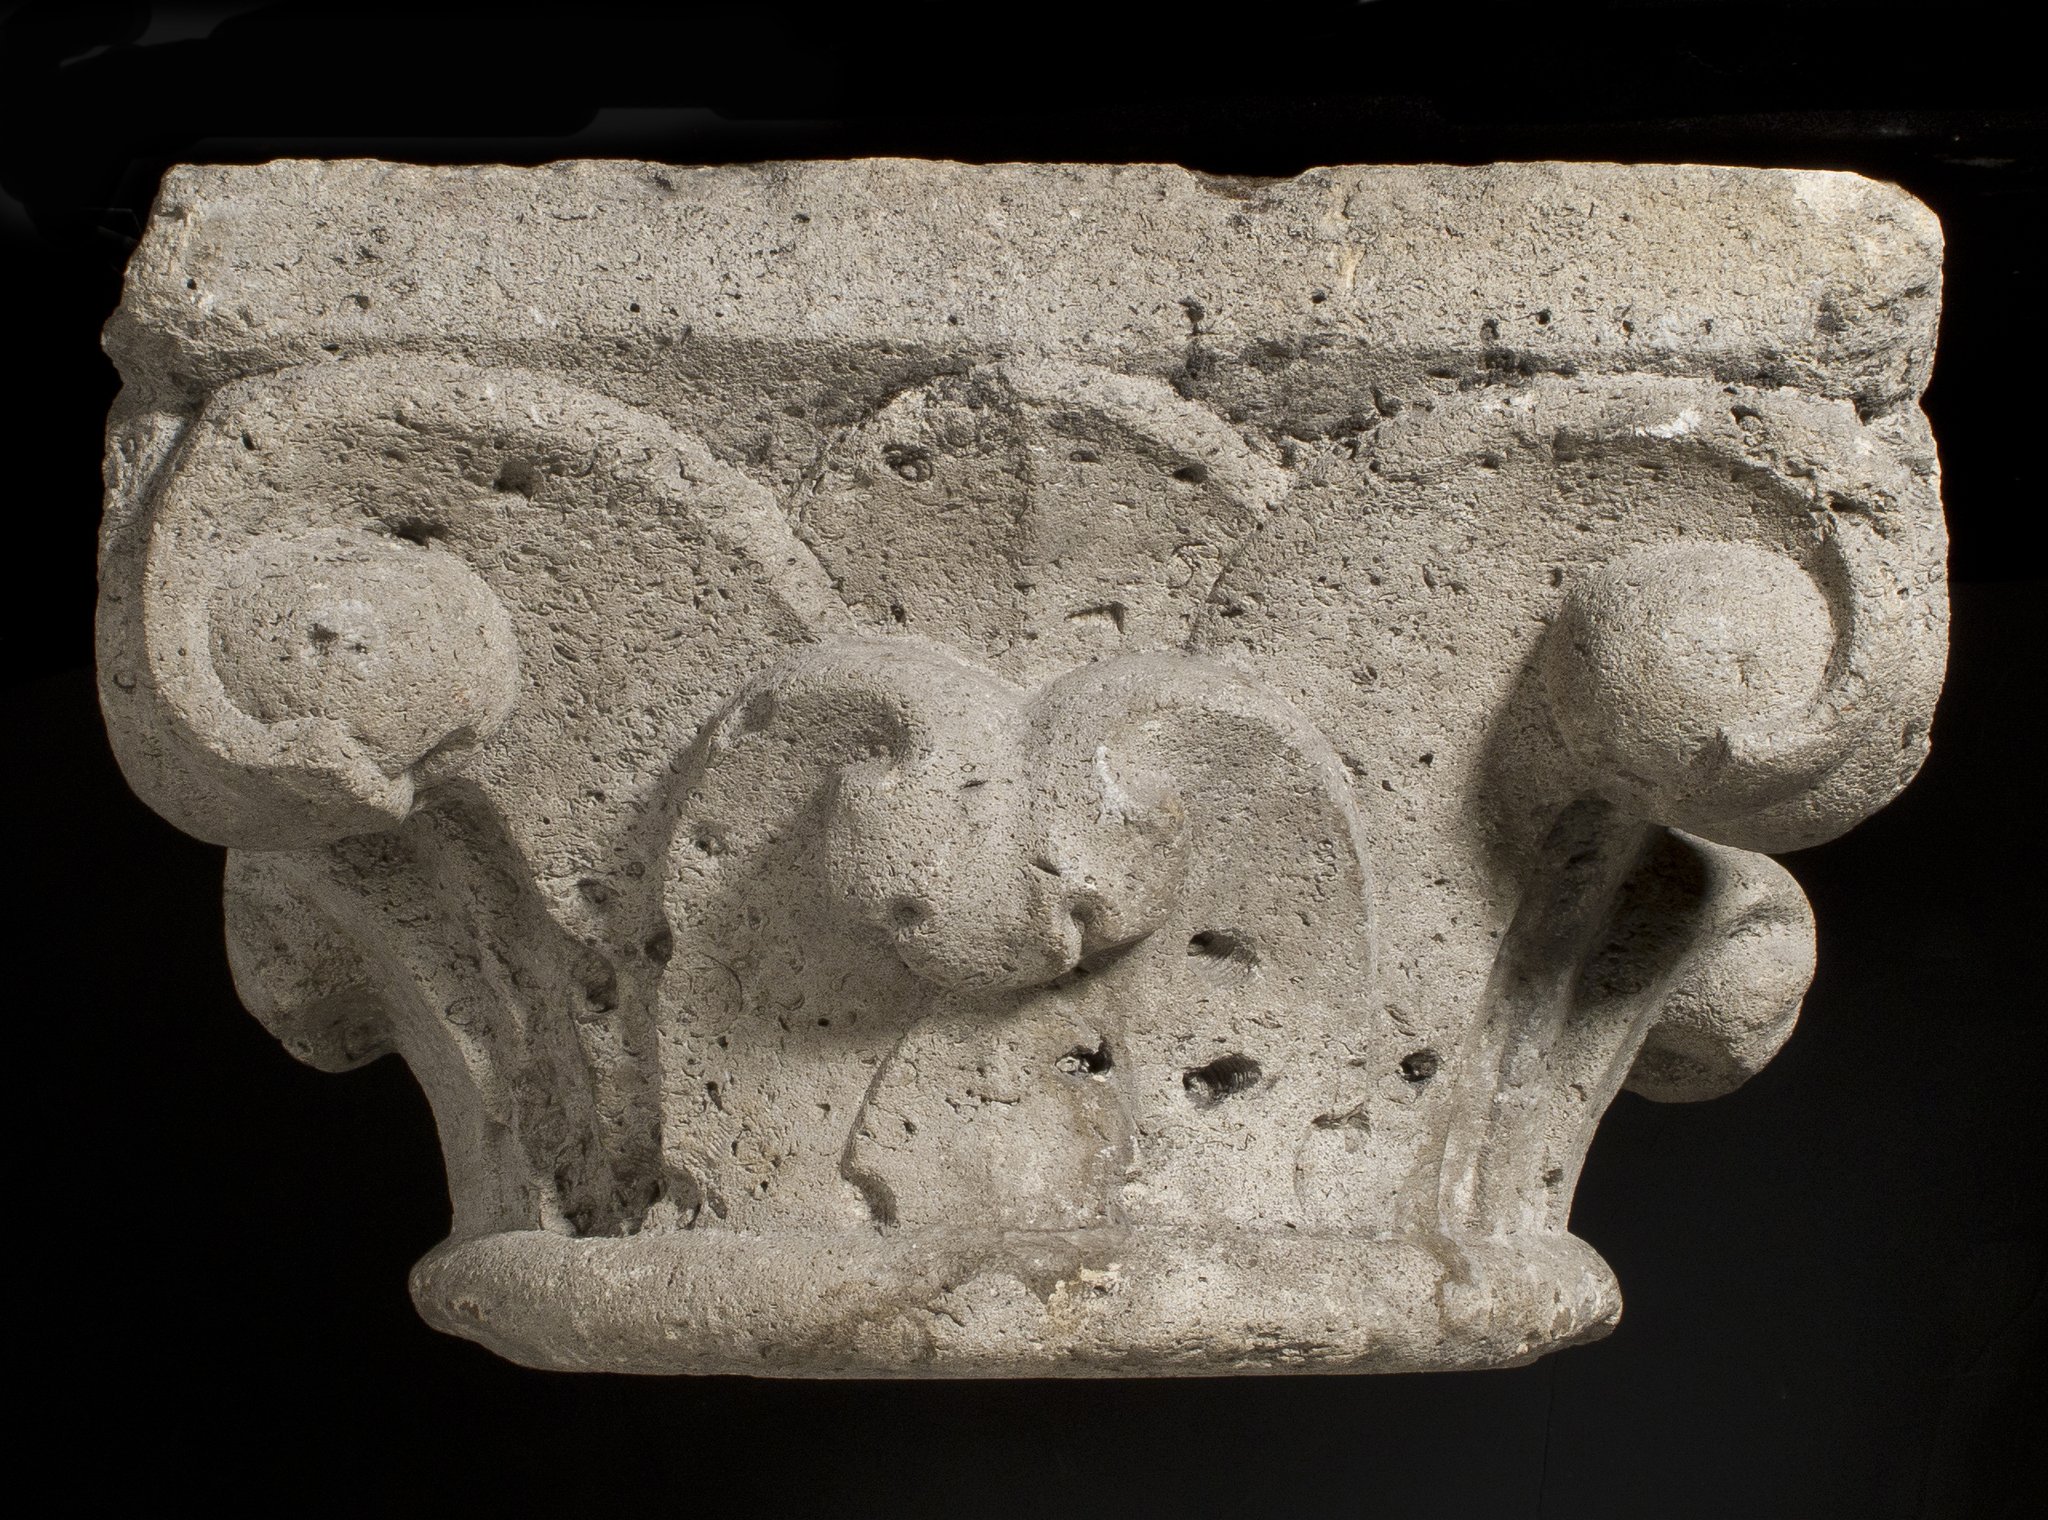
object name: capital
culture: french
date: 1101-1200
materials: stone